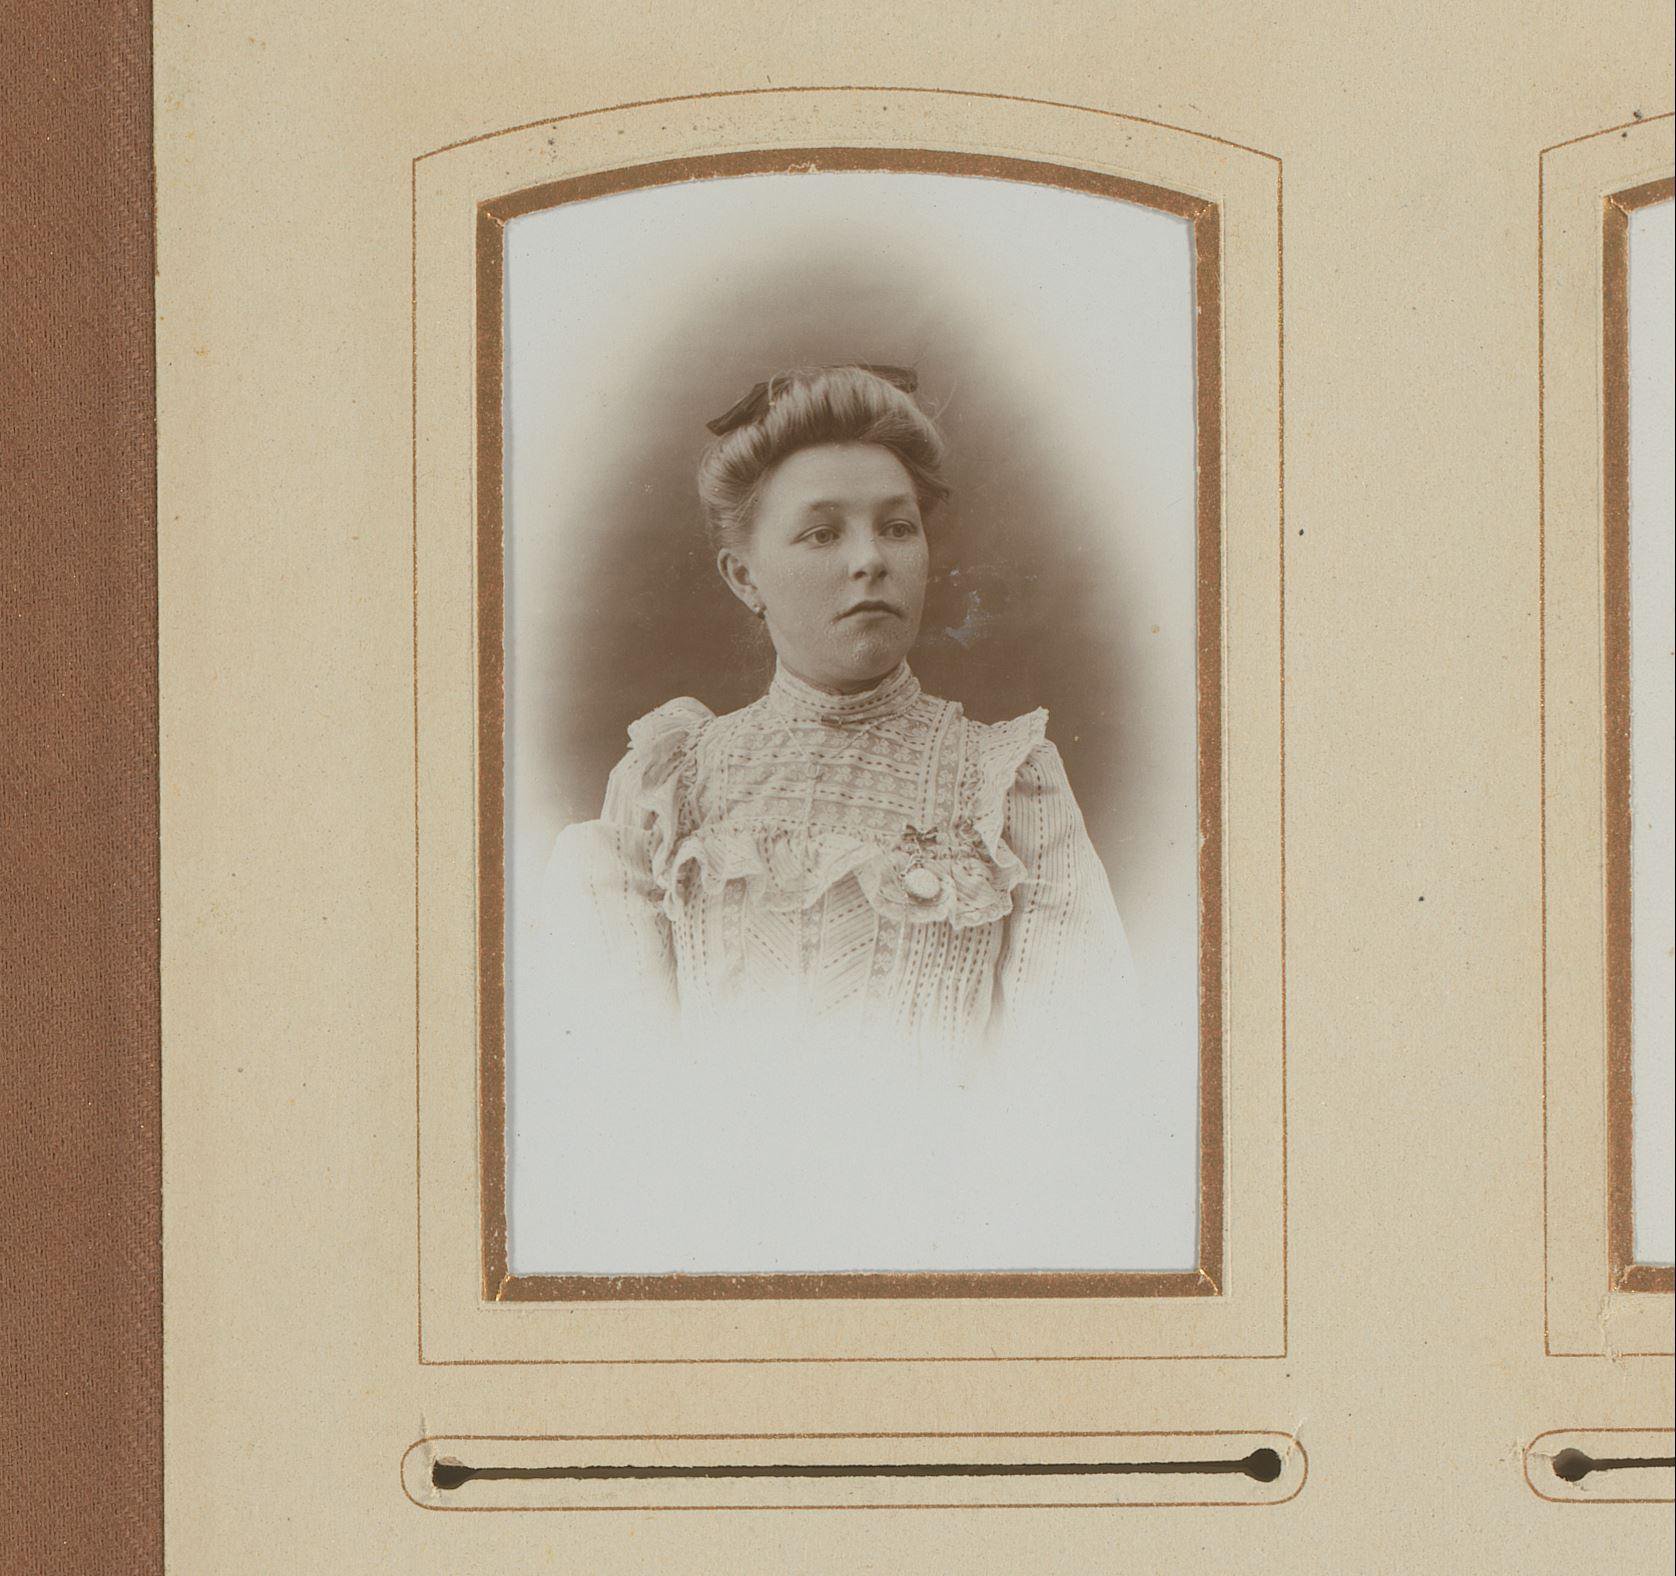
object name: album leaf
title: Portret van een jonge vrouw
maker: wilhelmus johannes van pampus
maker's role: fotograaf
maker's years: 1860-1920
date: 1887-1888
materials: cardboard, photographic support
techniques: collodion silver print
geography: amsterdam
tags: adolescent, young woman, maiden, historical persons - bb - woman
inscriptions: inscription: ‘Fotografie/ Excelsior/ Amsterdam/ Vijzelgracht 41./ De Plaat blijft voor nabestelling bewaard.’